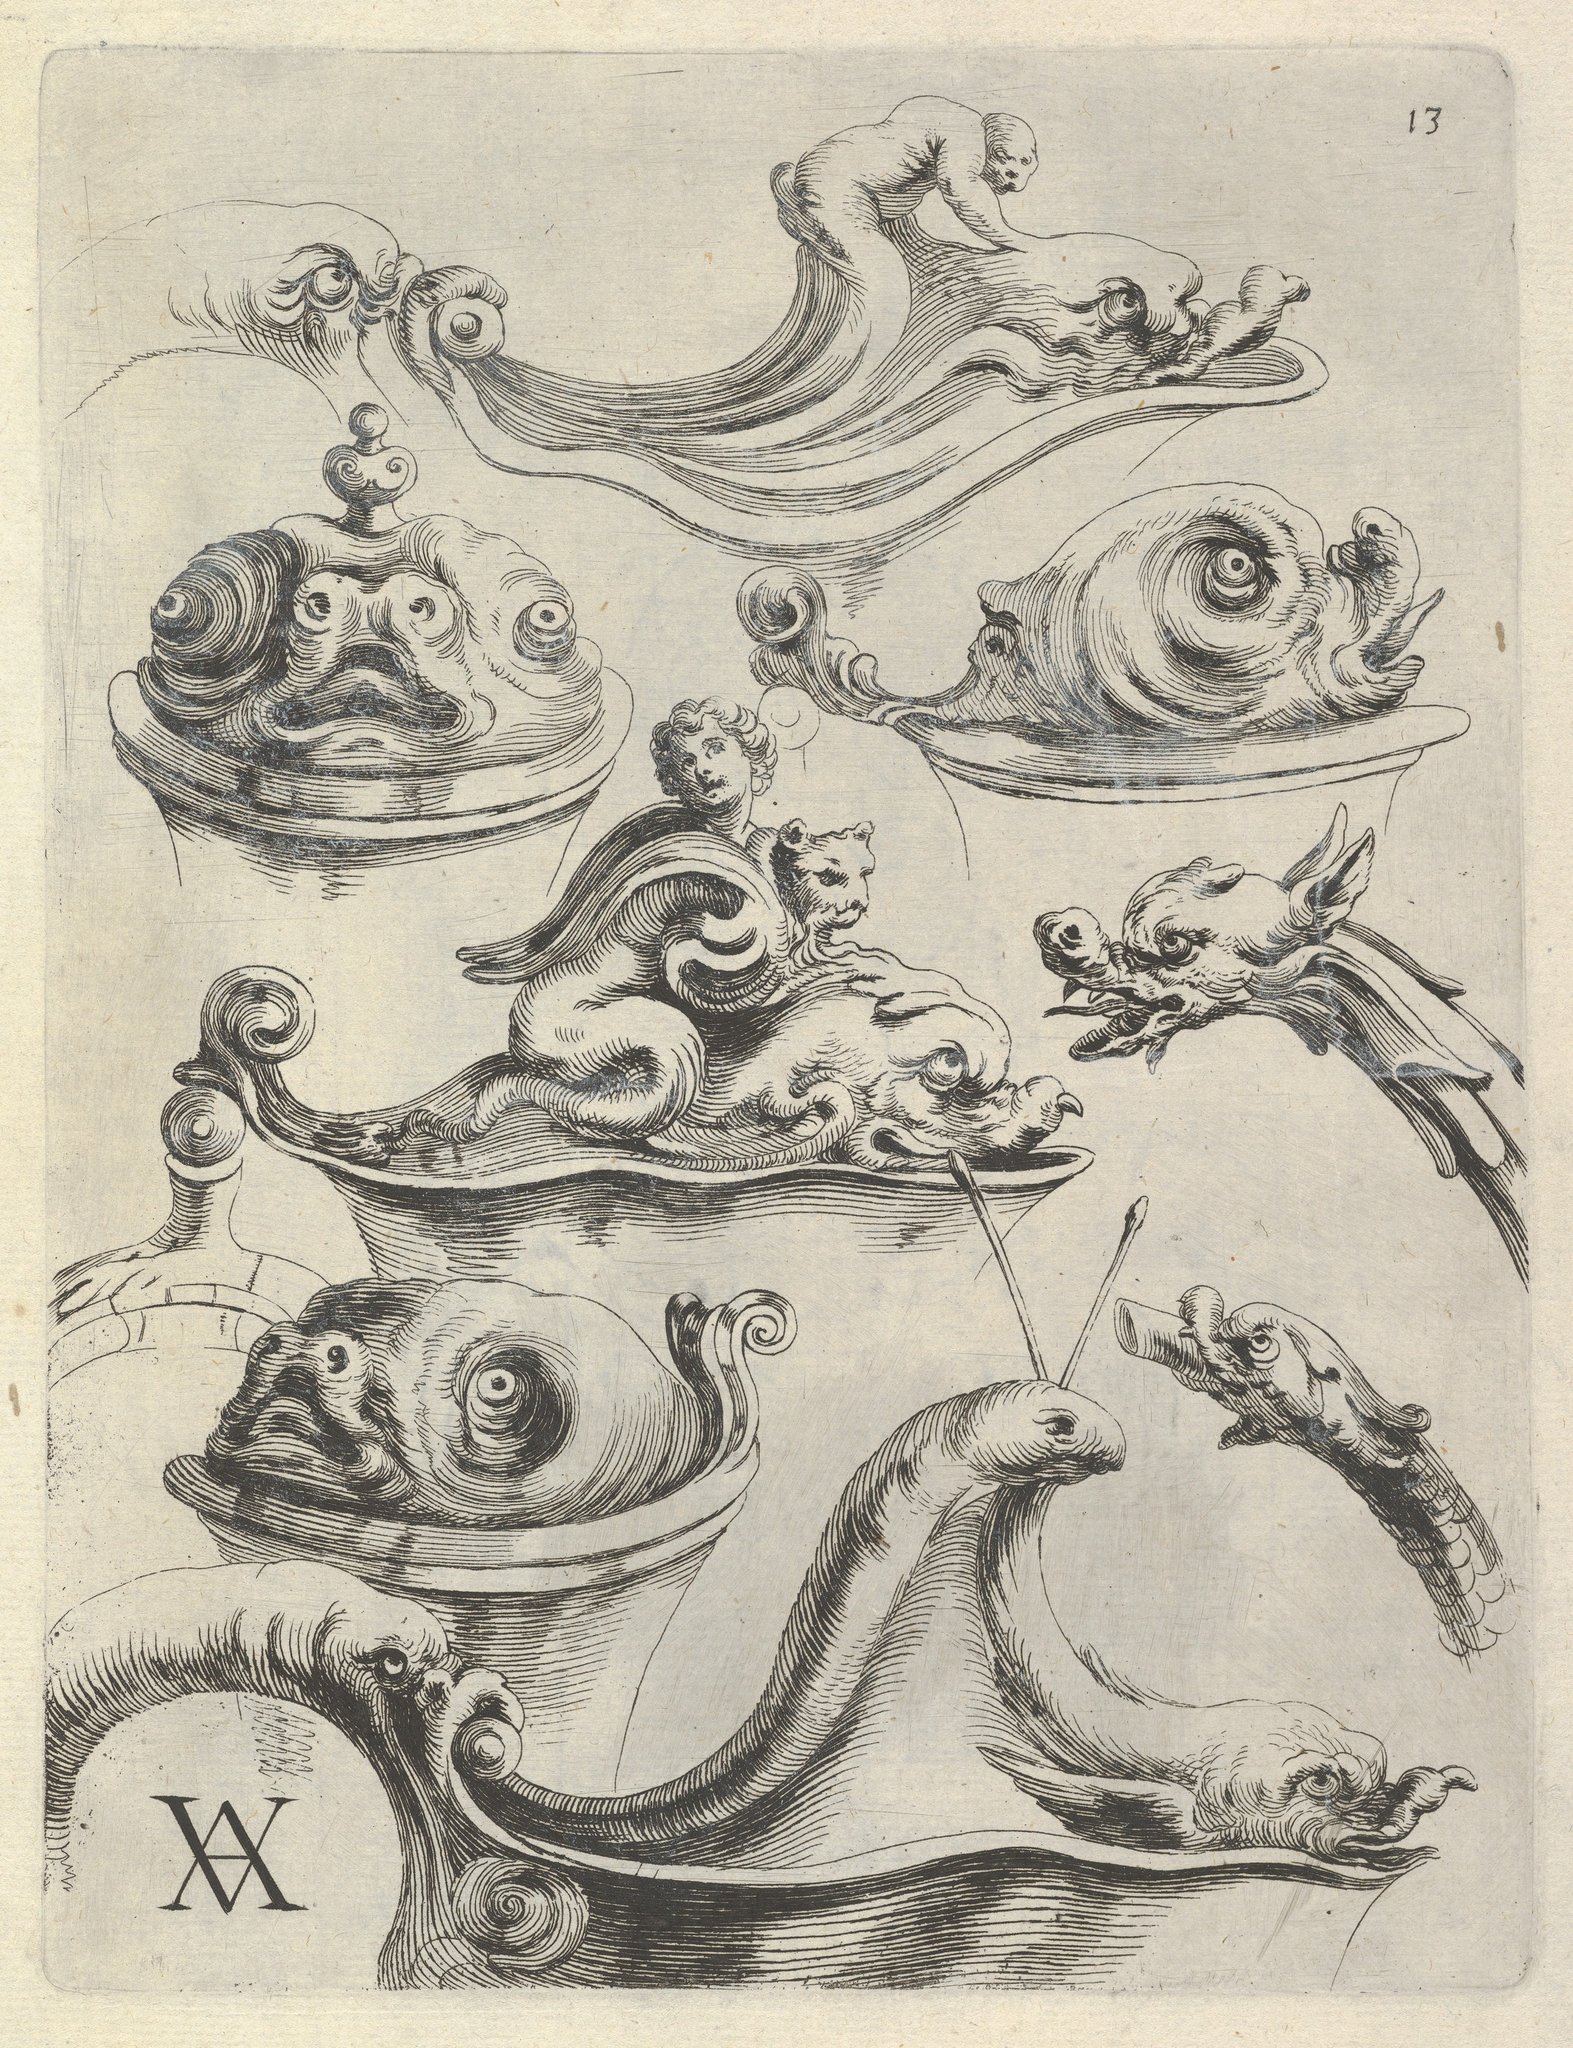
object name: album print ornament architecture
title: Plate 13, from "Modelli Artificiosi di Vasi diversi d'argento et altre Opere capriciozi (...), Parte prima"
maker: theodor van kessel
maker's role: artist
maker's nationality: dutch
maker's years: 1620-1660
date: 1646-1652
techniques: etching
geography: netherlands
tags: ornament